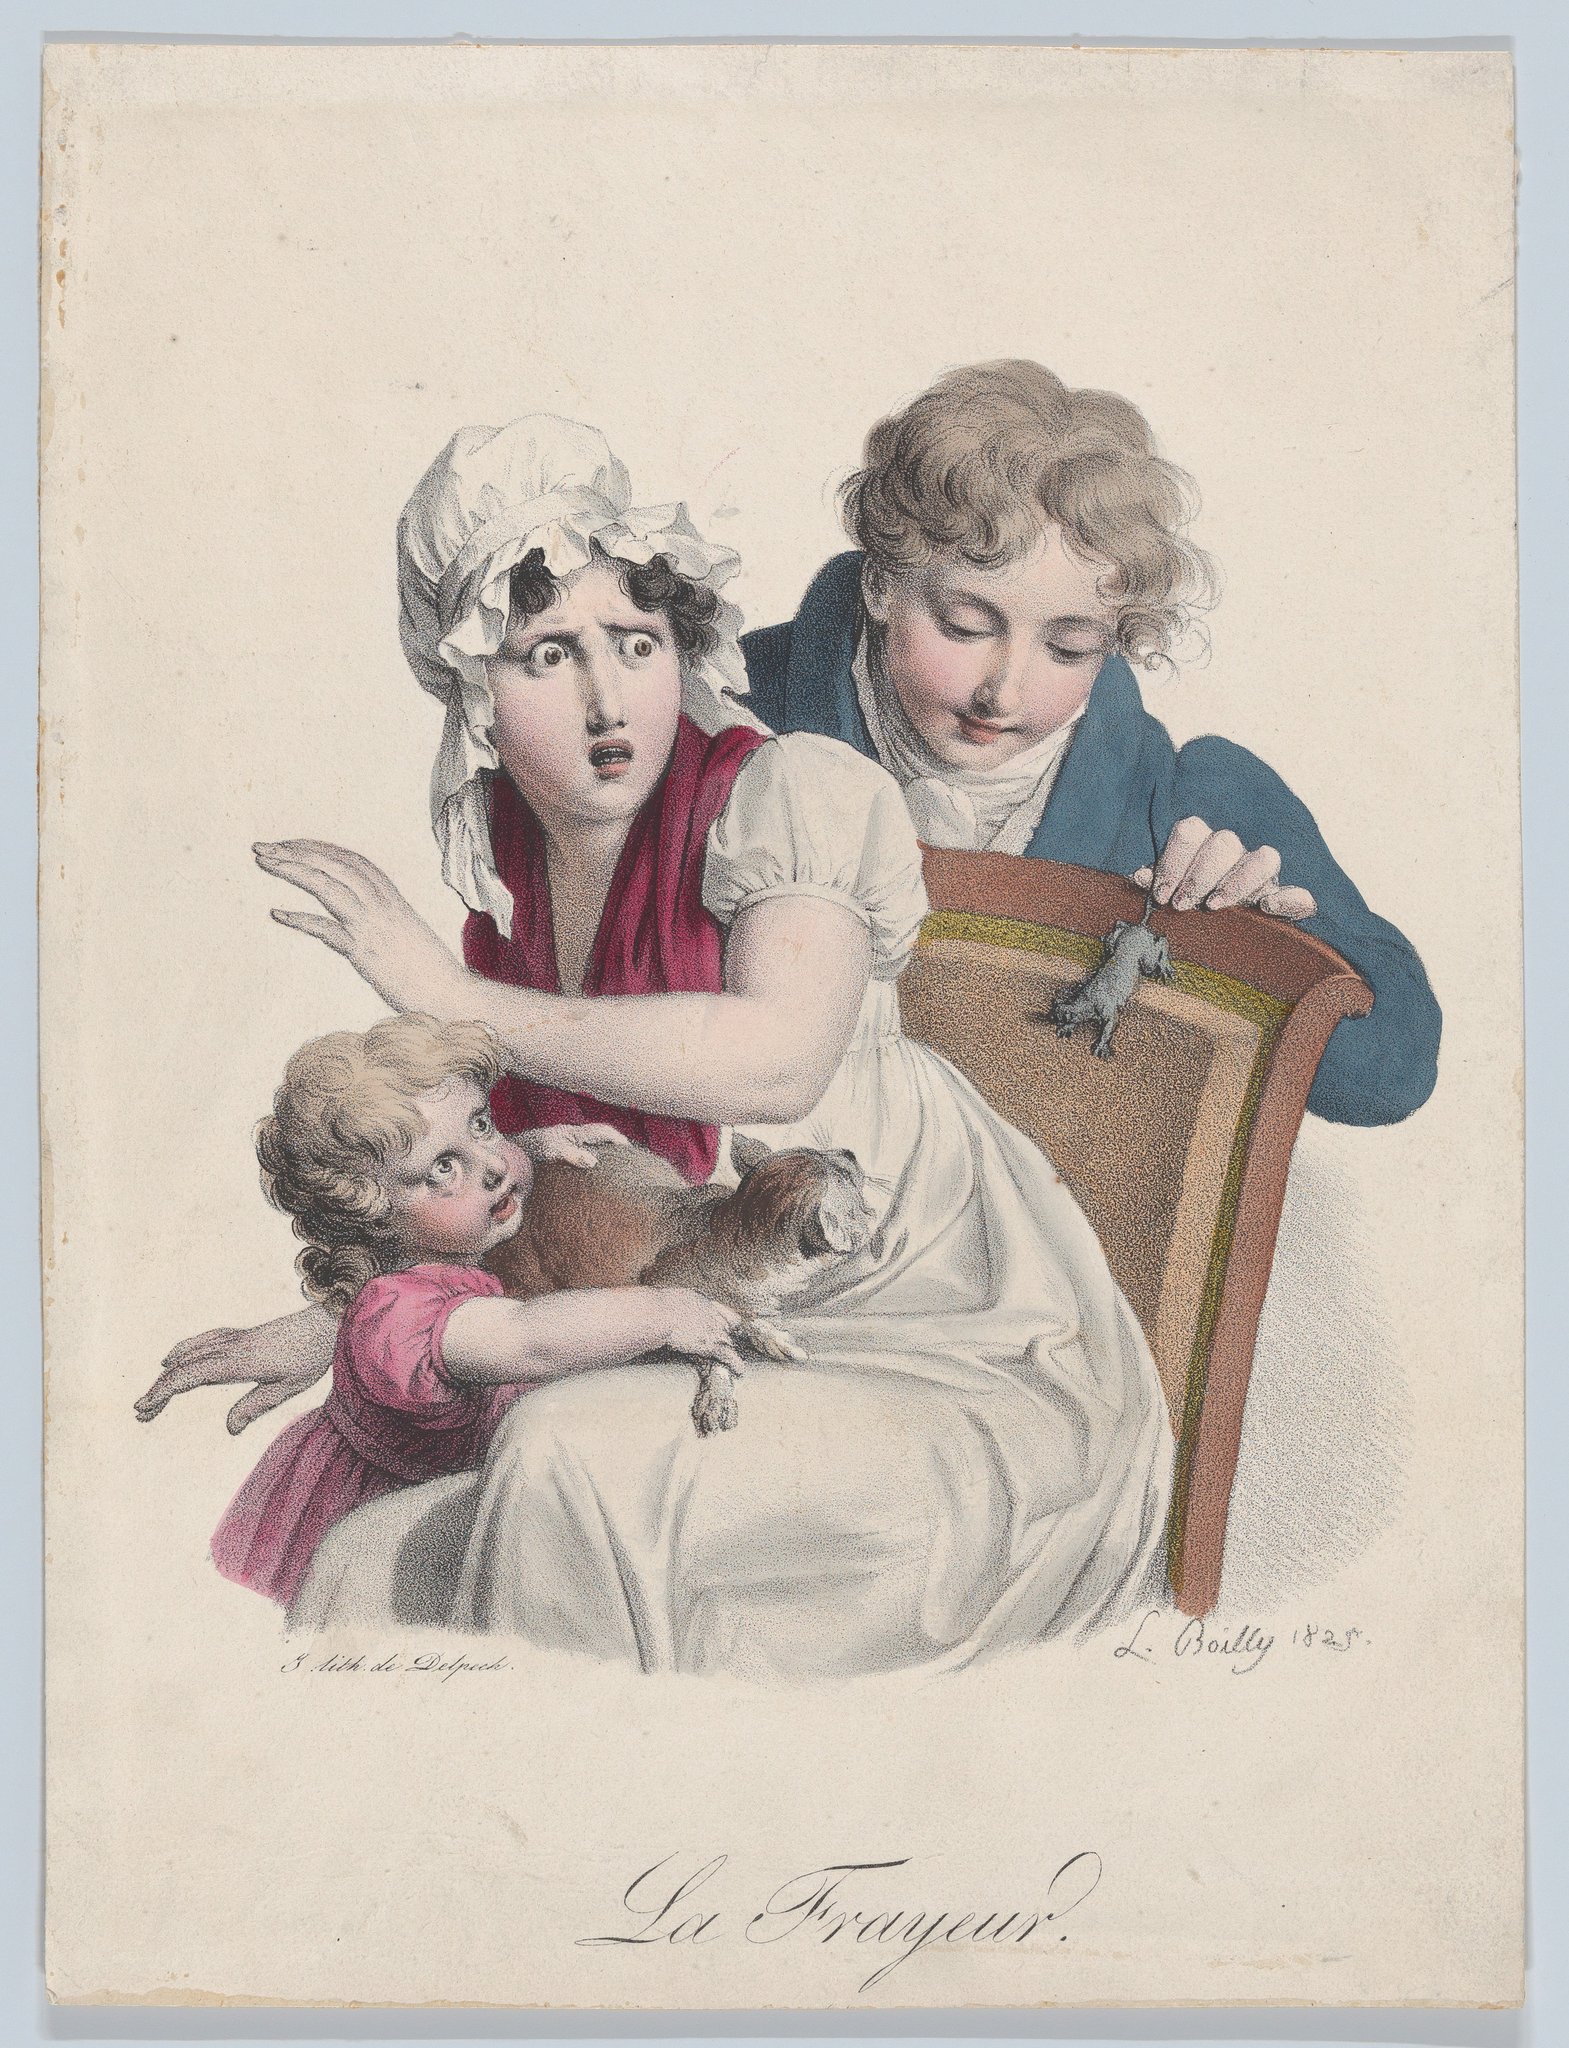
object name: print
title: Fear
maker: louis léopold boilly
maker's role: artist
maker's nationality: french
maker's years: 1761-1845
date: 1825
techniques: hand coloring, lithograph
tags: girls,men,women,cats,mice